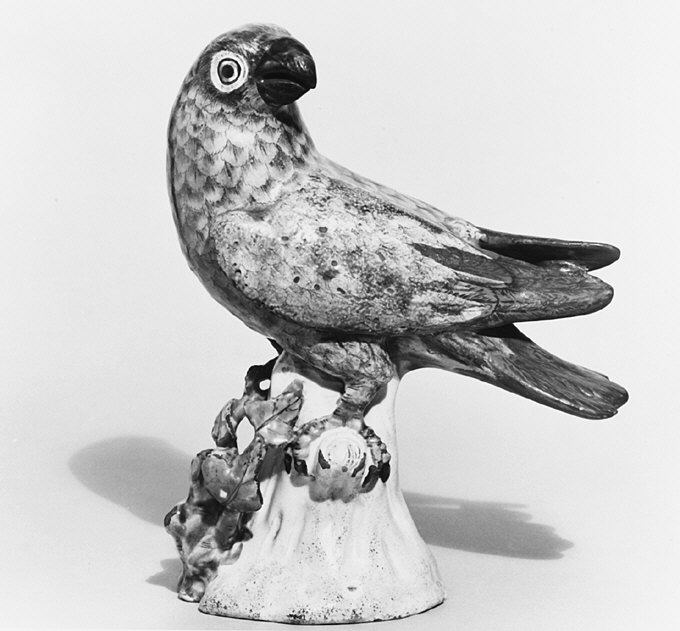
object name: figure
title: Parrot (one of a pair)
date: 1760-1770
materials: faience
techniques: glazing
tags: parrots